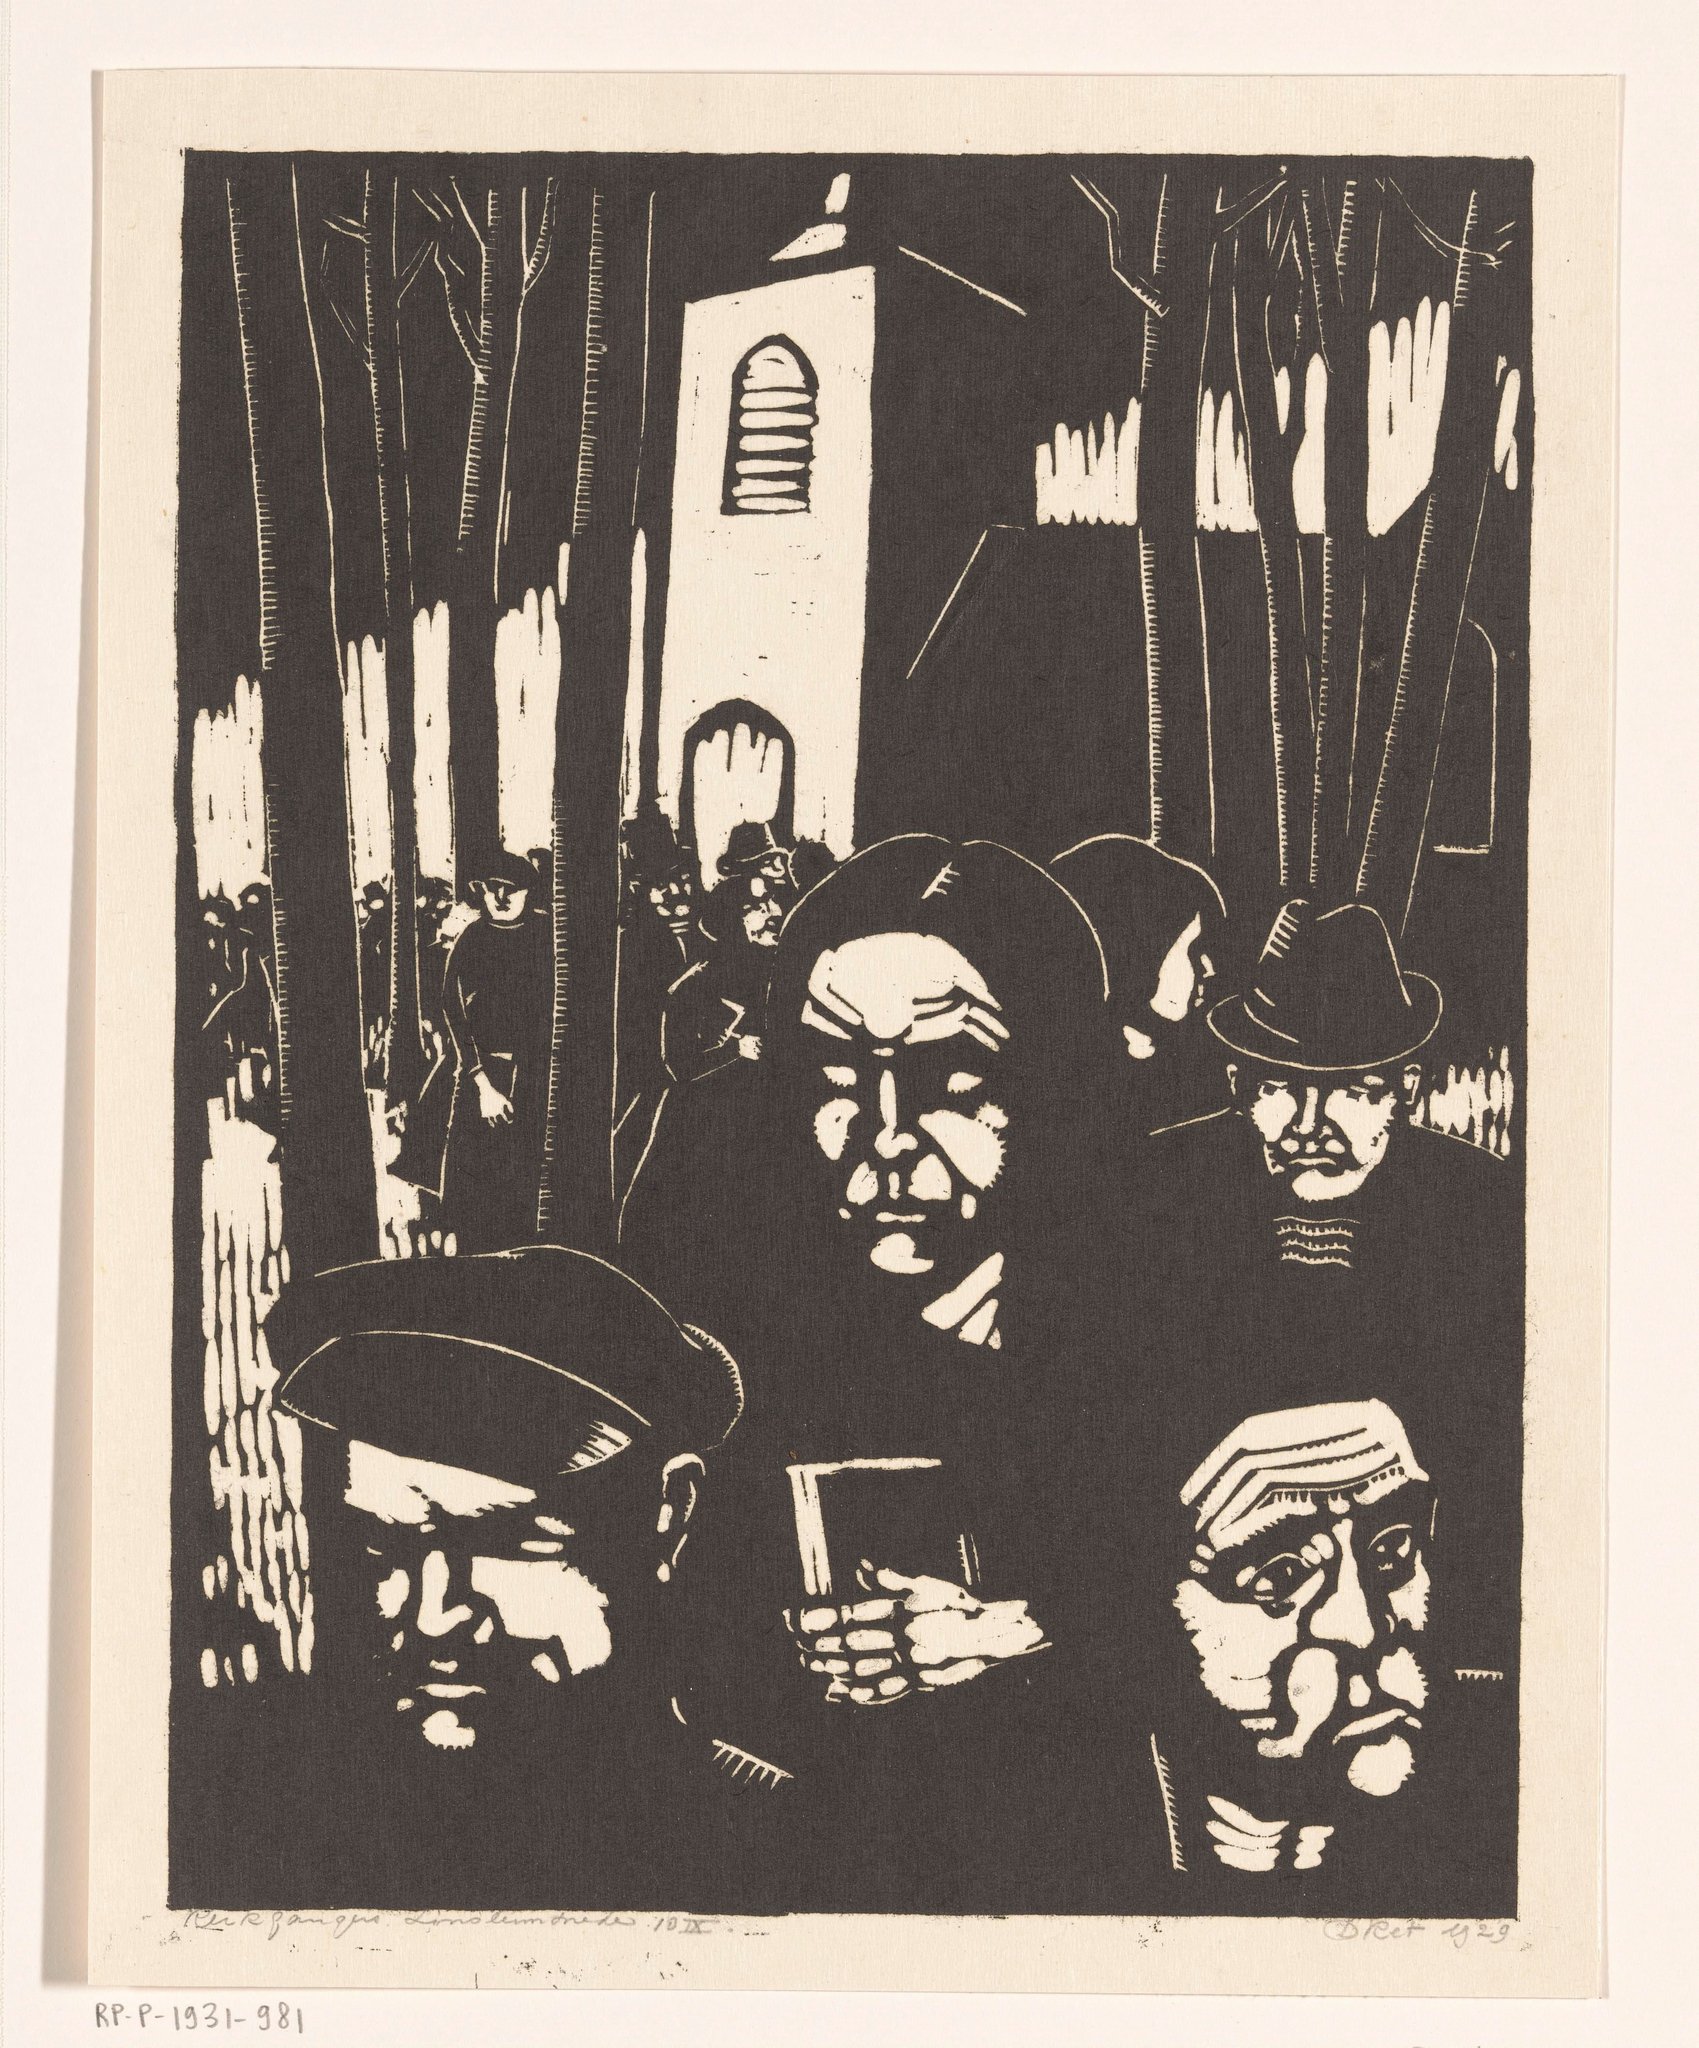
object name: print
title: Kerkgangers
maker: dick ket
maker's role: draughtsman, print maker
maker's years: 1902-1940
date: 1929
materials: paper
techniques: woodcut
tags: bridge in city across river, canal, etc.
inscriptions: collector's mark: Lugt 2228